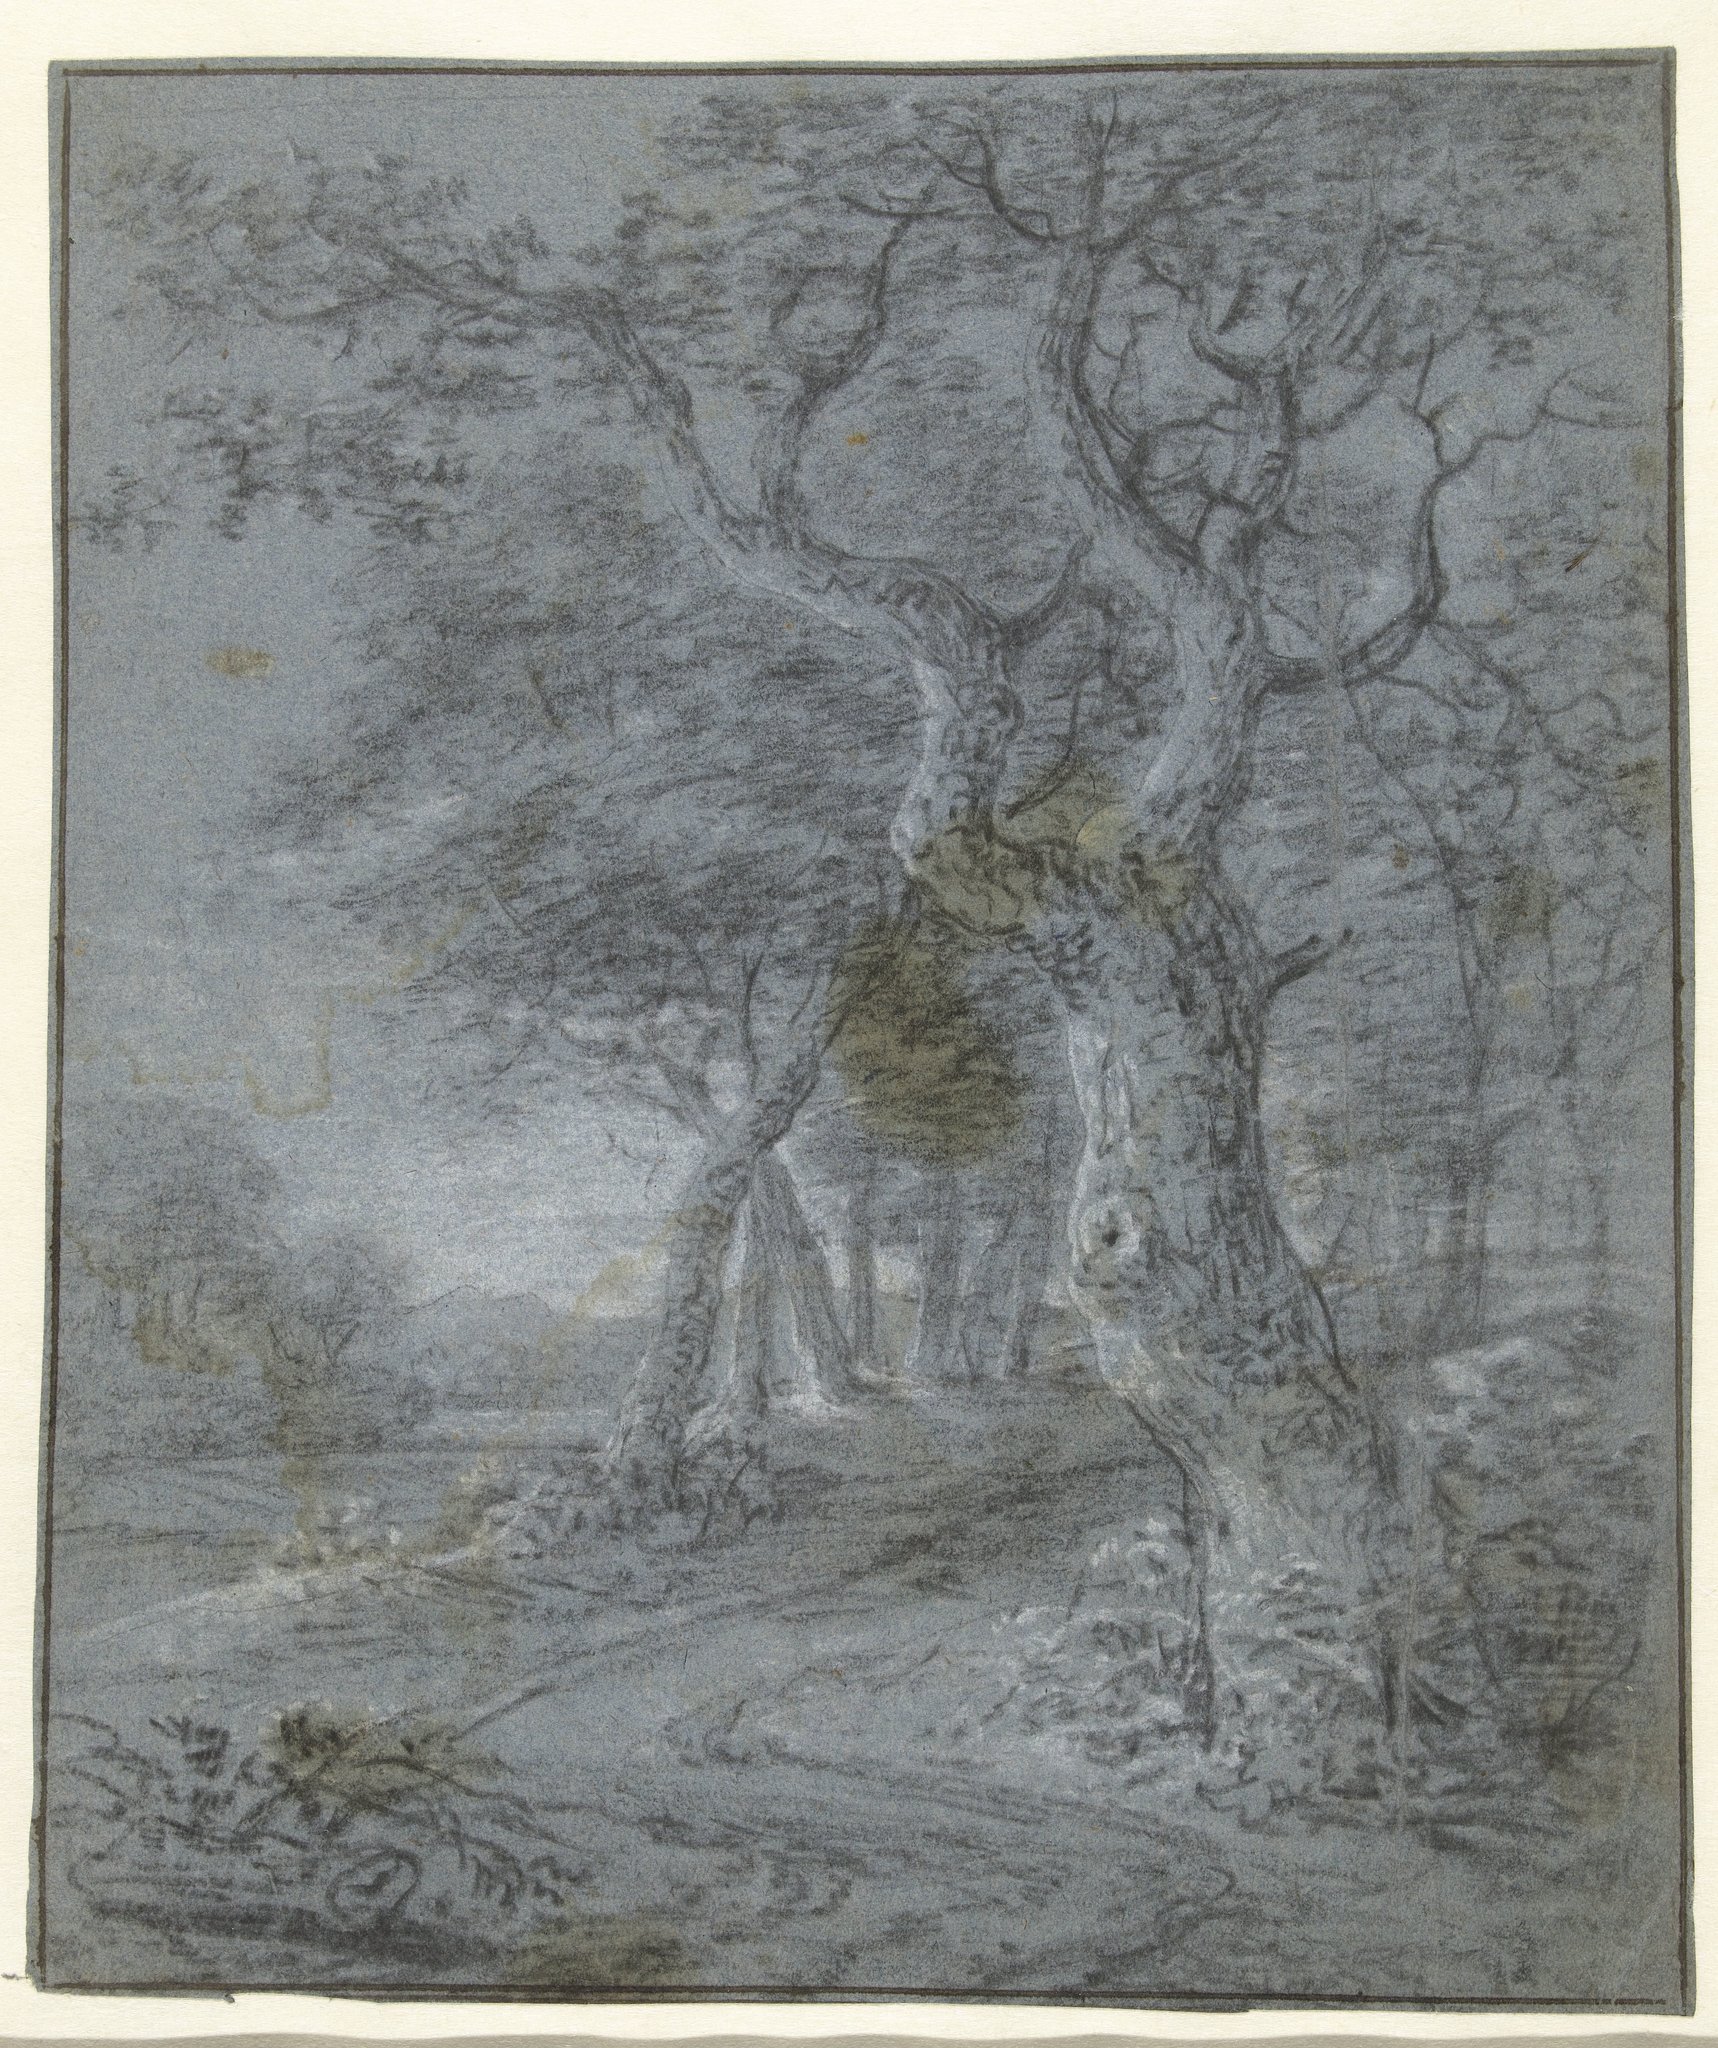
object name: drawing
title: Pad waarlangs bomen staan in een heuvellandschap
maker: simon de vlieger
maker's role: draughtsman, painter, print maker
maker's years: 1600-1653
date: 1610-1653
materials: chalk, paper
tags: low hill country